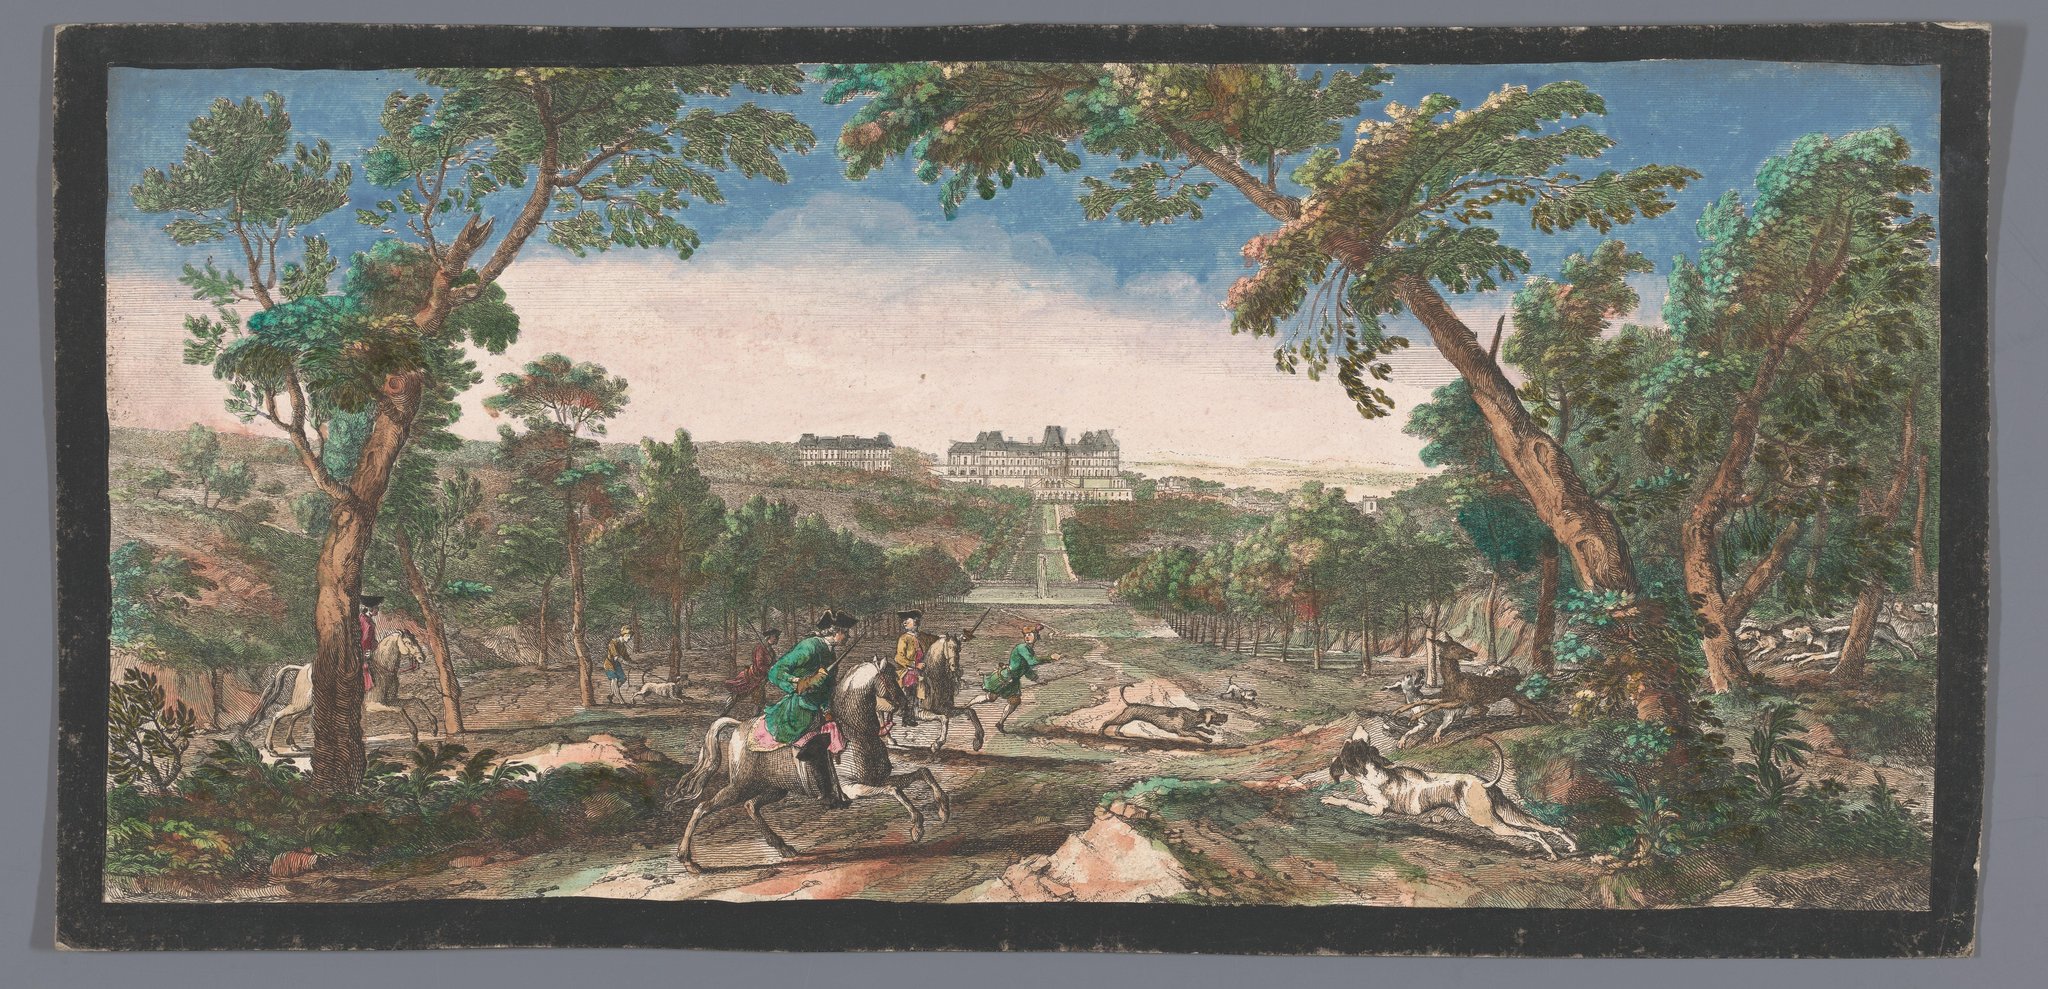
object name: print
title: Gezicht op de tuin van het Château de Meudon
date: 1700-1799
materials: cardboard, paper, watercolor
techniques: brush, etching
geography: paris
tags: hunting, chase, garden, garden fountain, civic architecture; edifices; dwellings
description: Op de voorgrond een jacht met ruiters en jachthonden. Op de achtergrond het Château de Meudon.